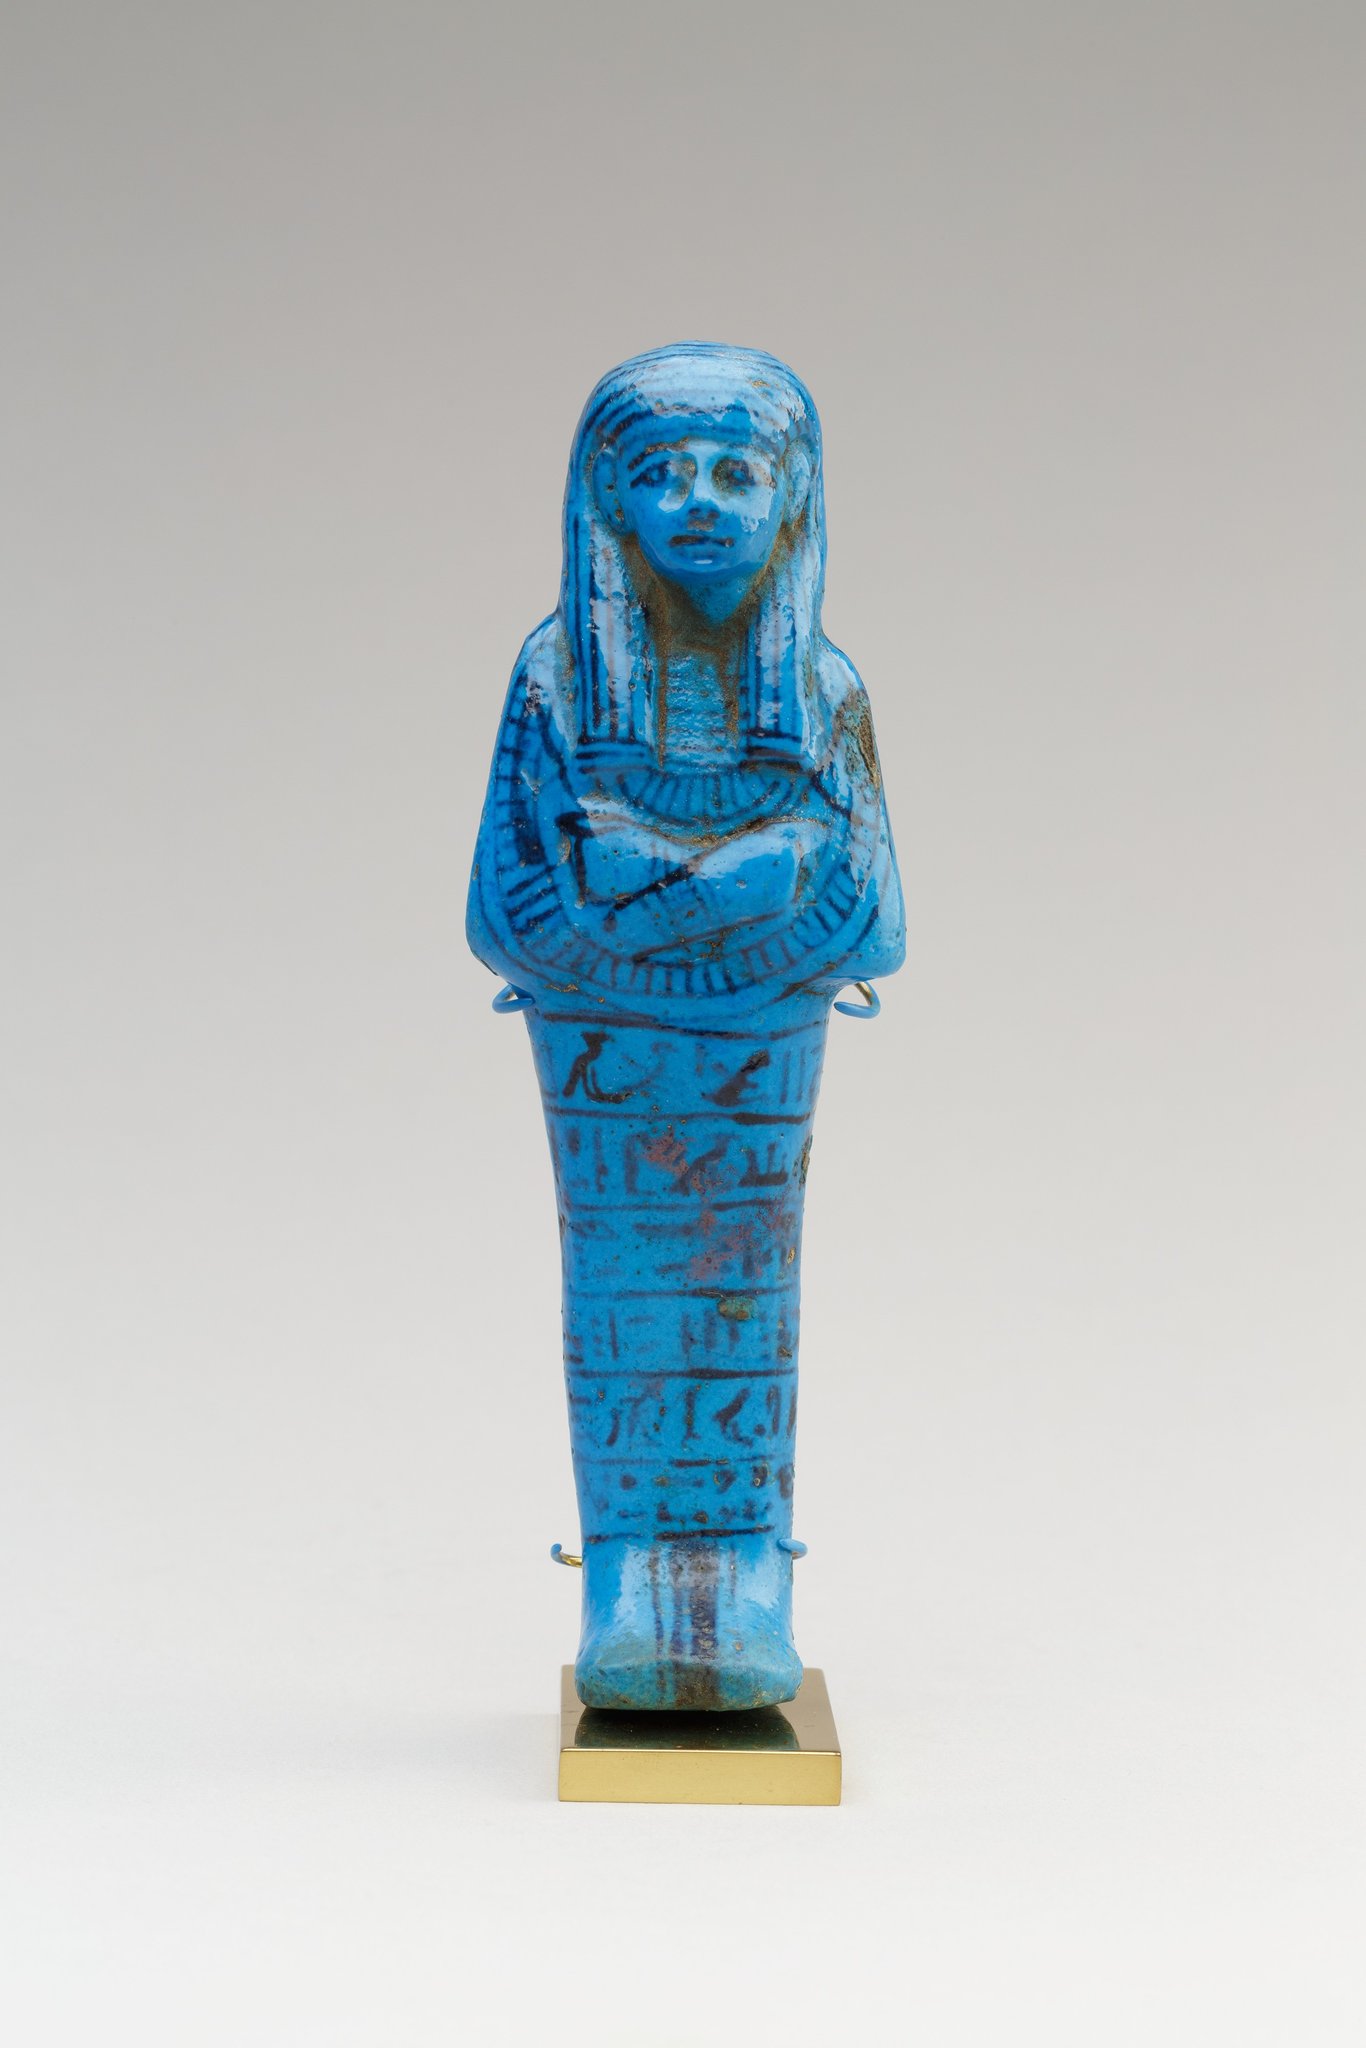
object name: shabti, paser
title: Shabti of Paser, the Vizier of Seti I and Ramesses II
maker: paser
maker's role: patron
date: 1294-1213 BCE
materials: faience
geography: egypt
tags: hieroglyphs